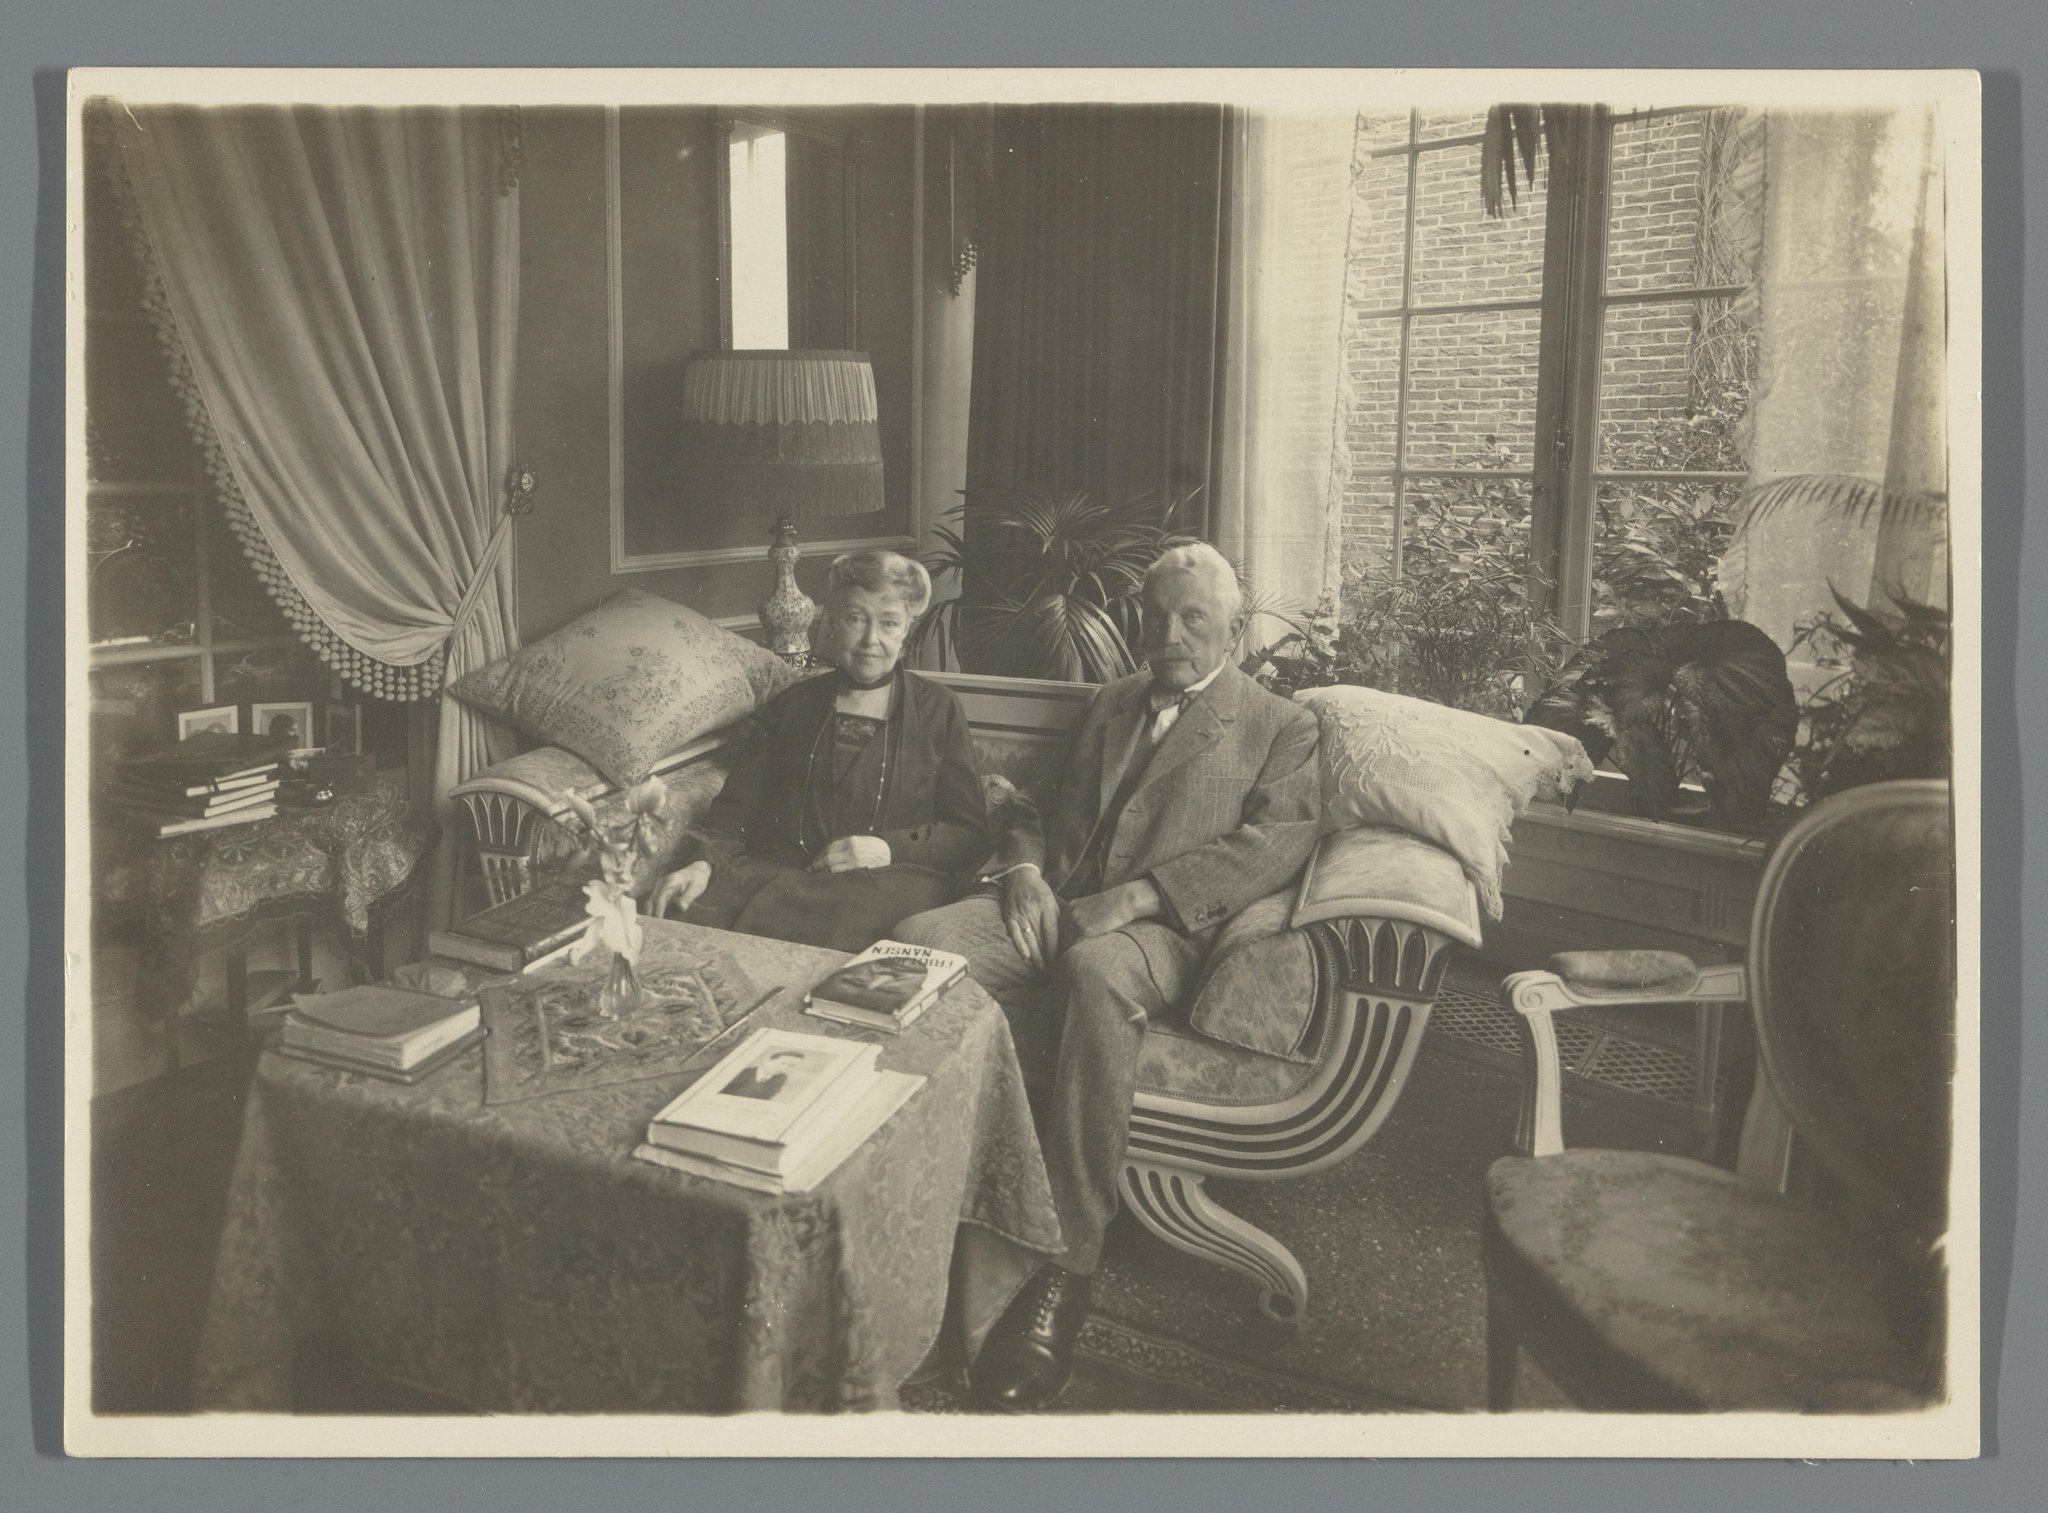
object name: photograph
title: Portret van Sophia Wilhelmina van Taack Tra Kranen en jhr. Frederik Teding van Berkhout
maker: Anonymous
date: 1920-1935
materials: photographic support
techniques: photography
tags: batavia, haarlem, historical persons - bb - woman, historical persons, communal rooms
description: Portret van echtpaar Sophia Wilhelmina van Taack Tra Kranen en jhr. Frederik Teding van Berkhout, zittend op een sofa in de kamer voor een tafel met boeken.